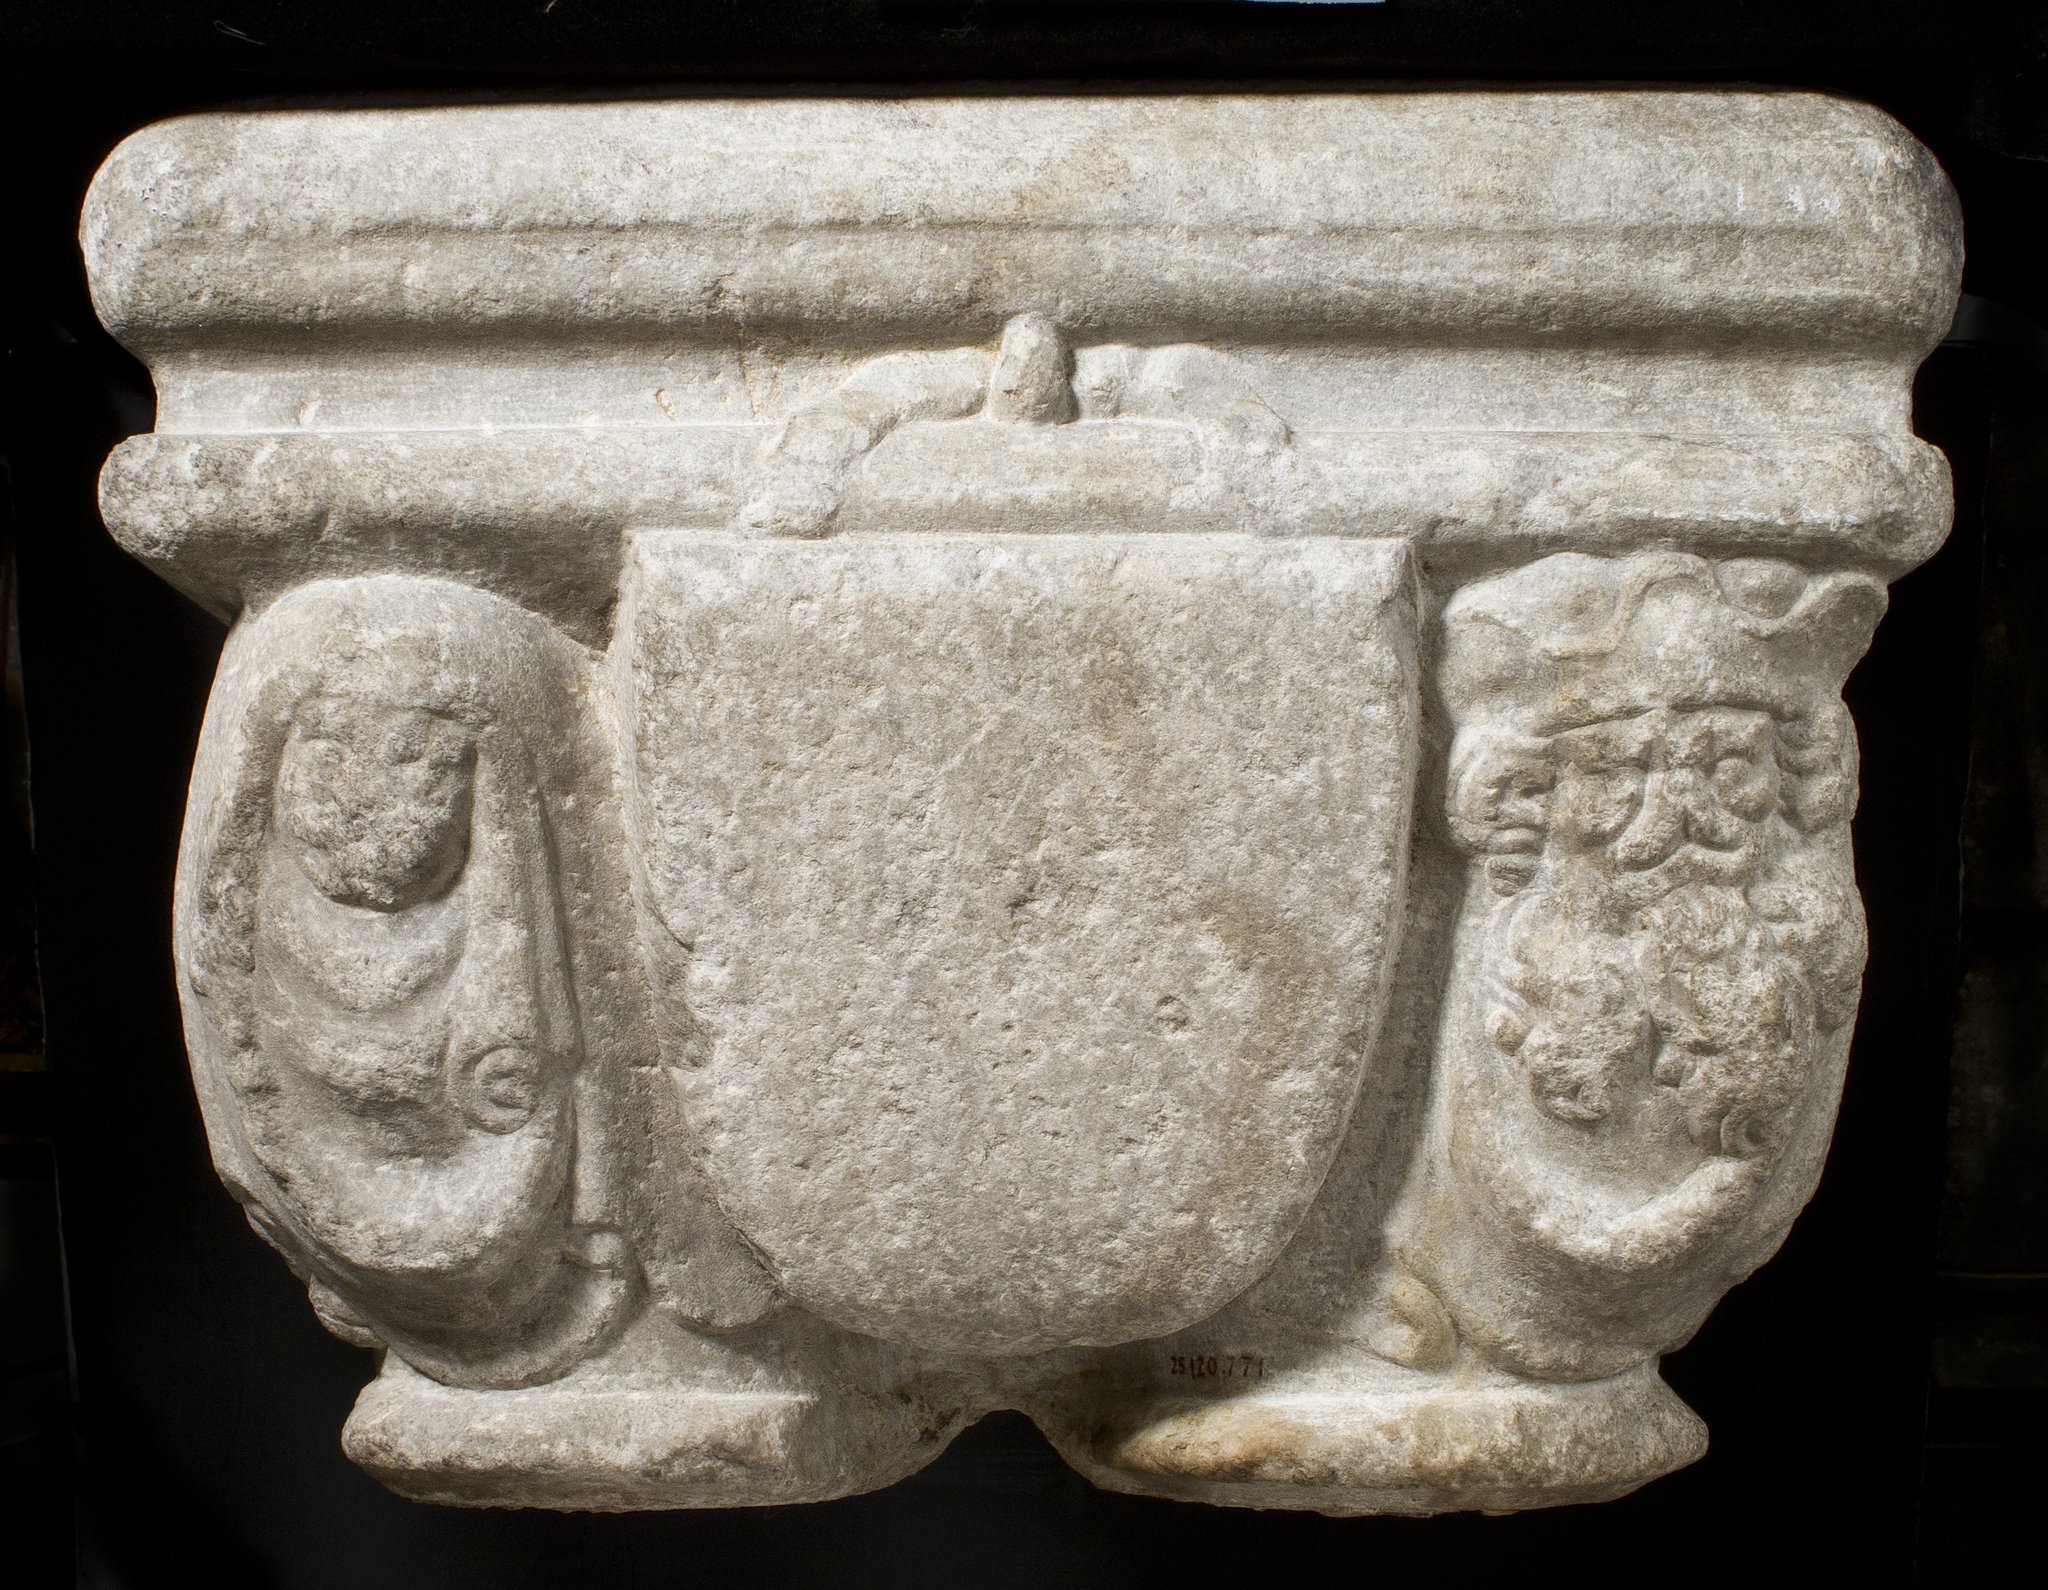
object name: capital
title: Double Capital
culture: french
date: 1267-1333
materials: marble